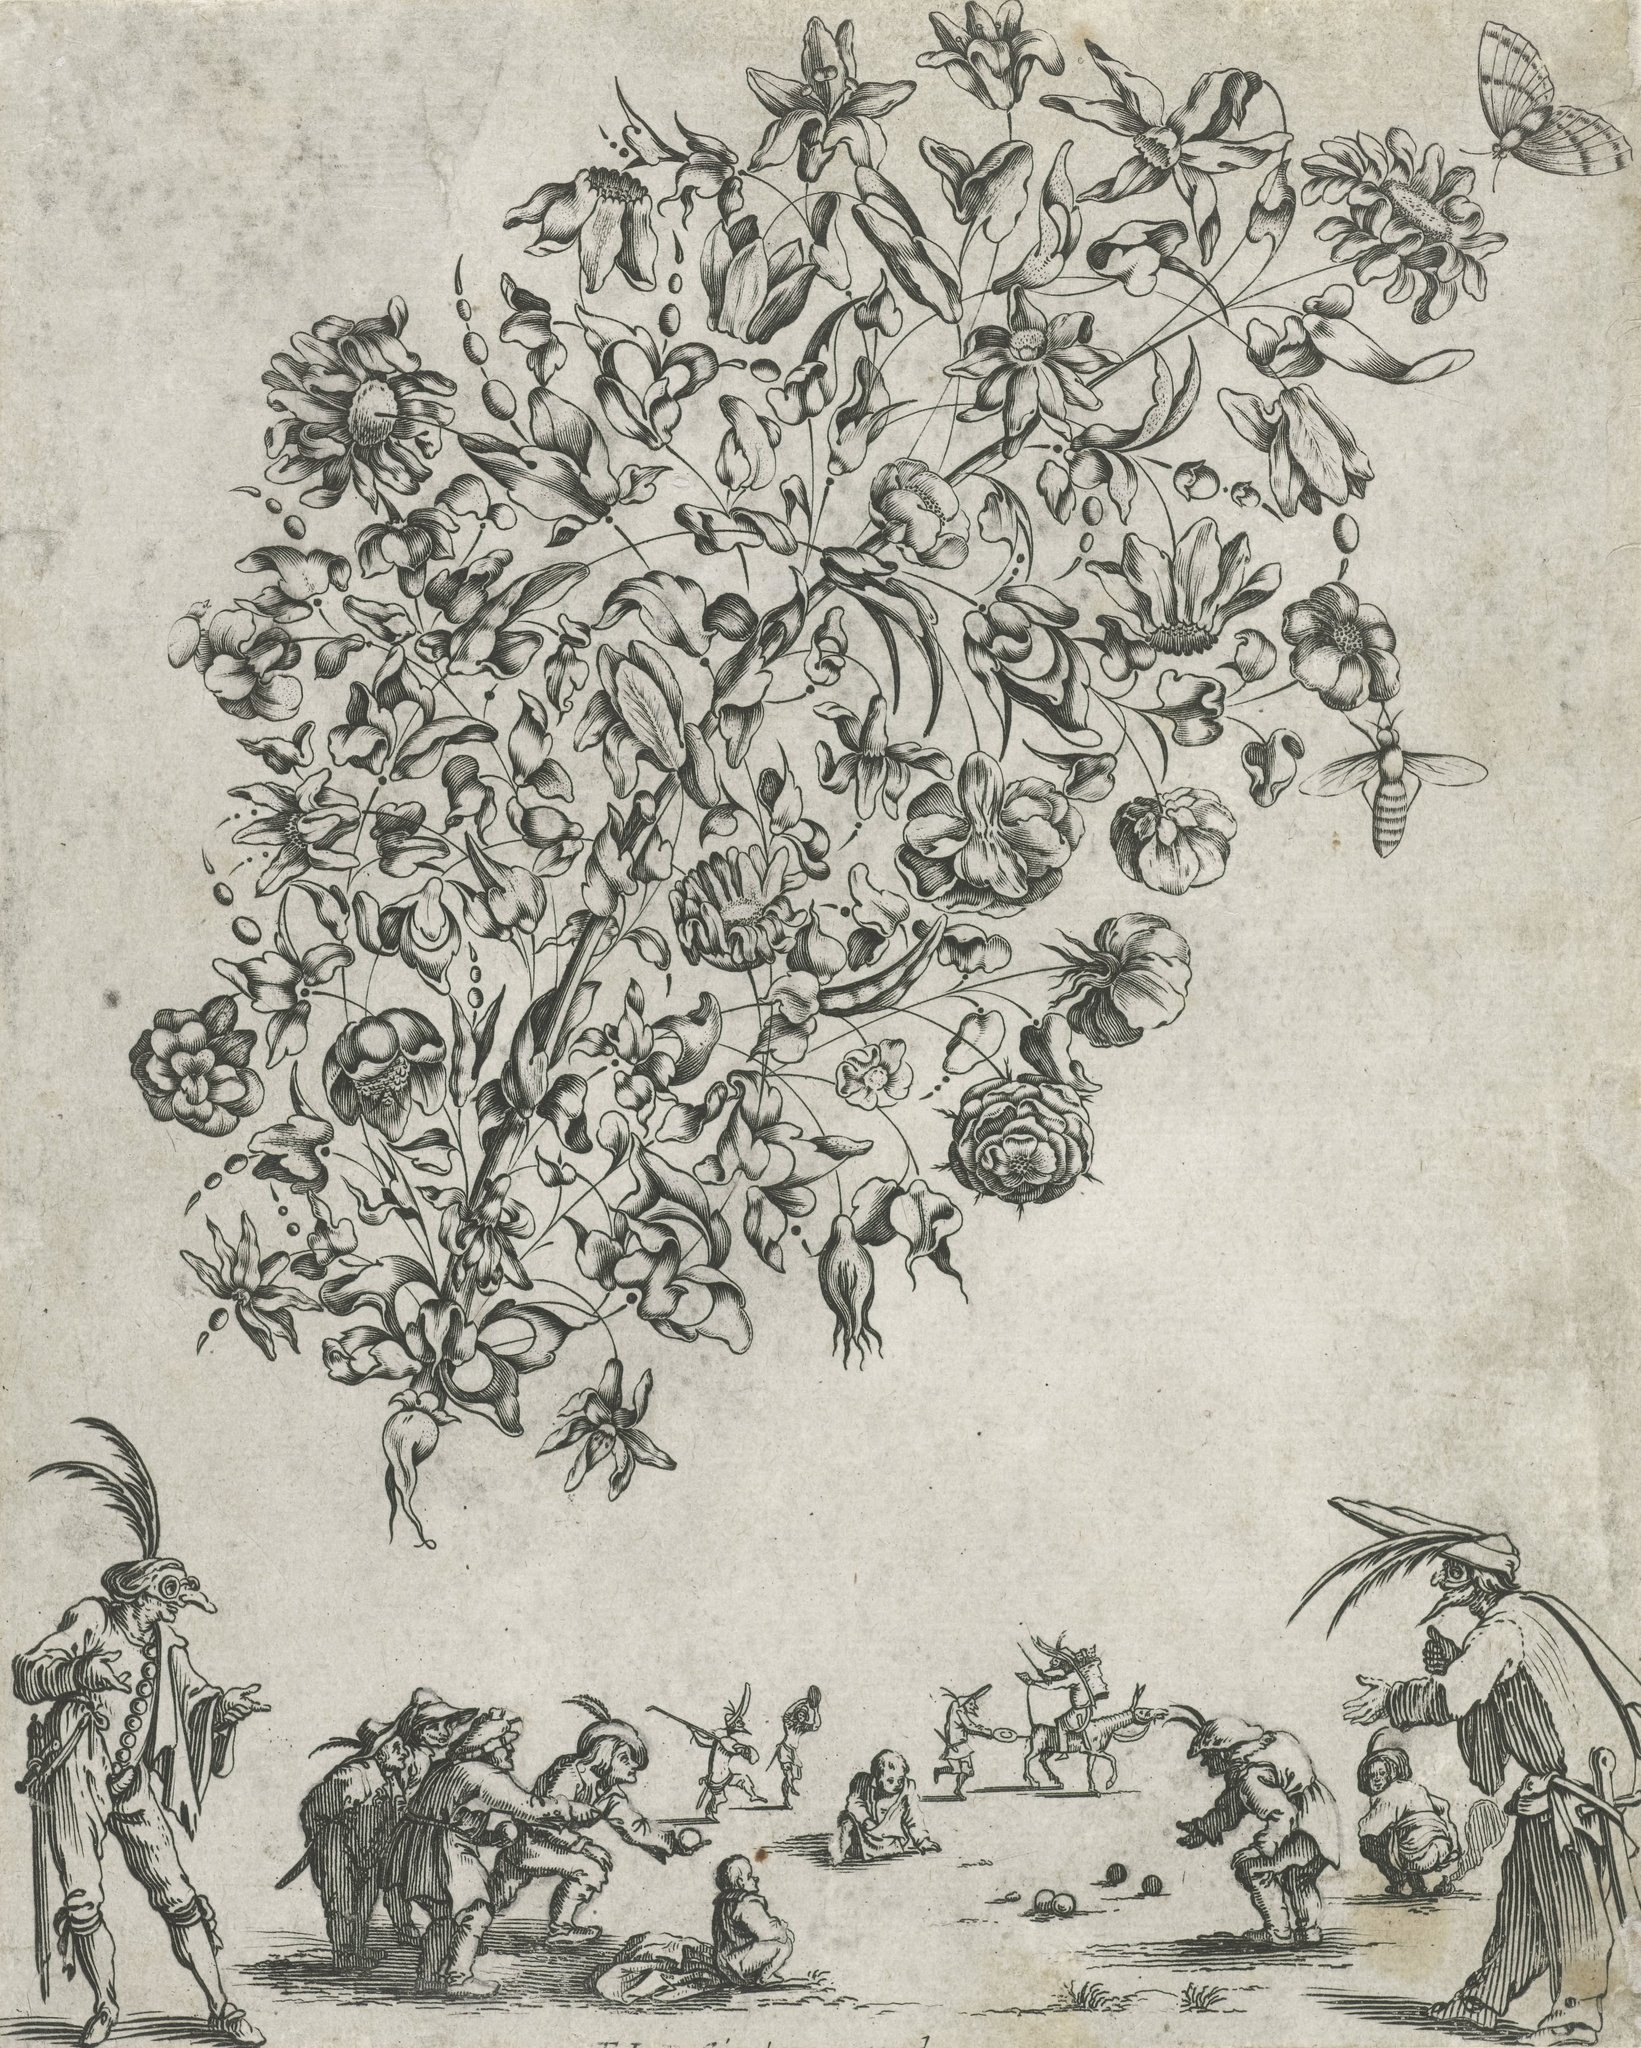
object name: ornament print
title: Boeket van ranken met bloemen en bladeren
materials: paper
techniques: engraving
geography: france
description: Met rechtsboven een vlinder en een wesp, onderaan een aantal figuren naar Jacques Callot. Blad 2 uit serie met 6 boeketten voor goud- en zilversmeden. Tweede editie.